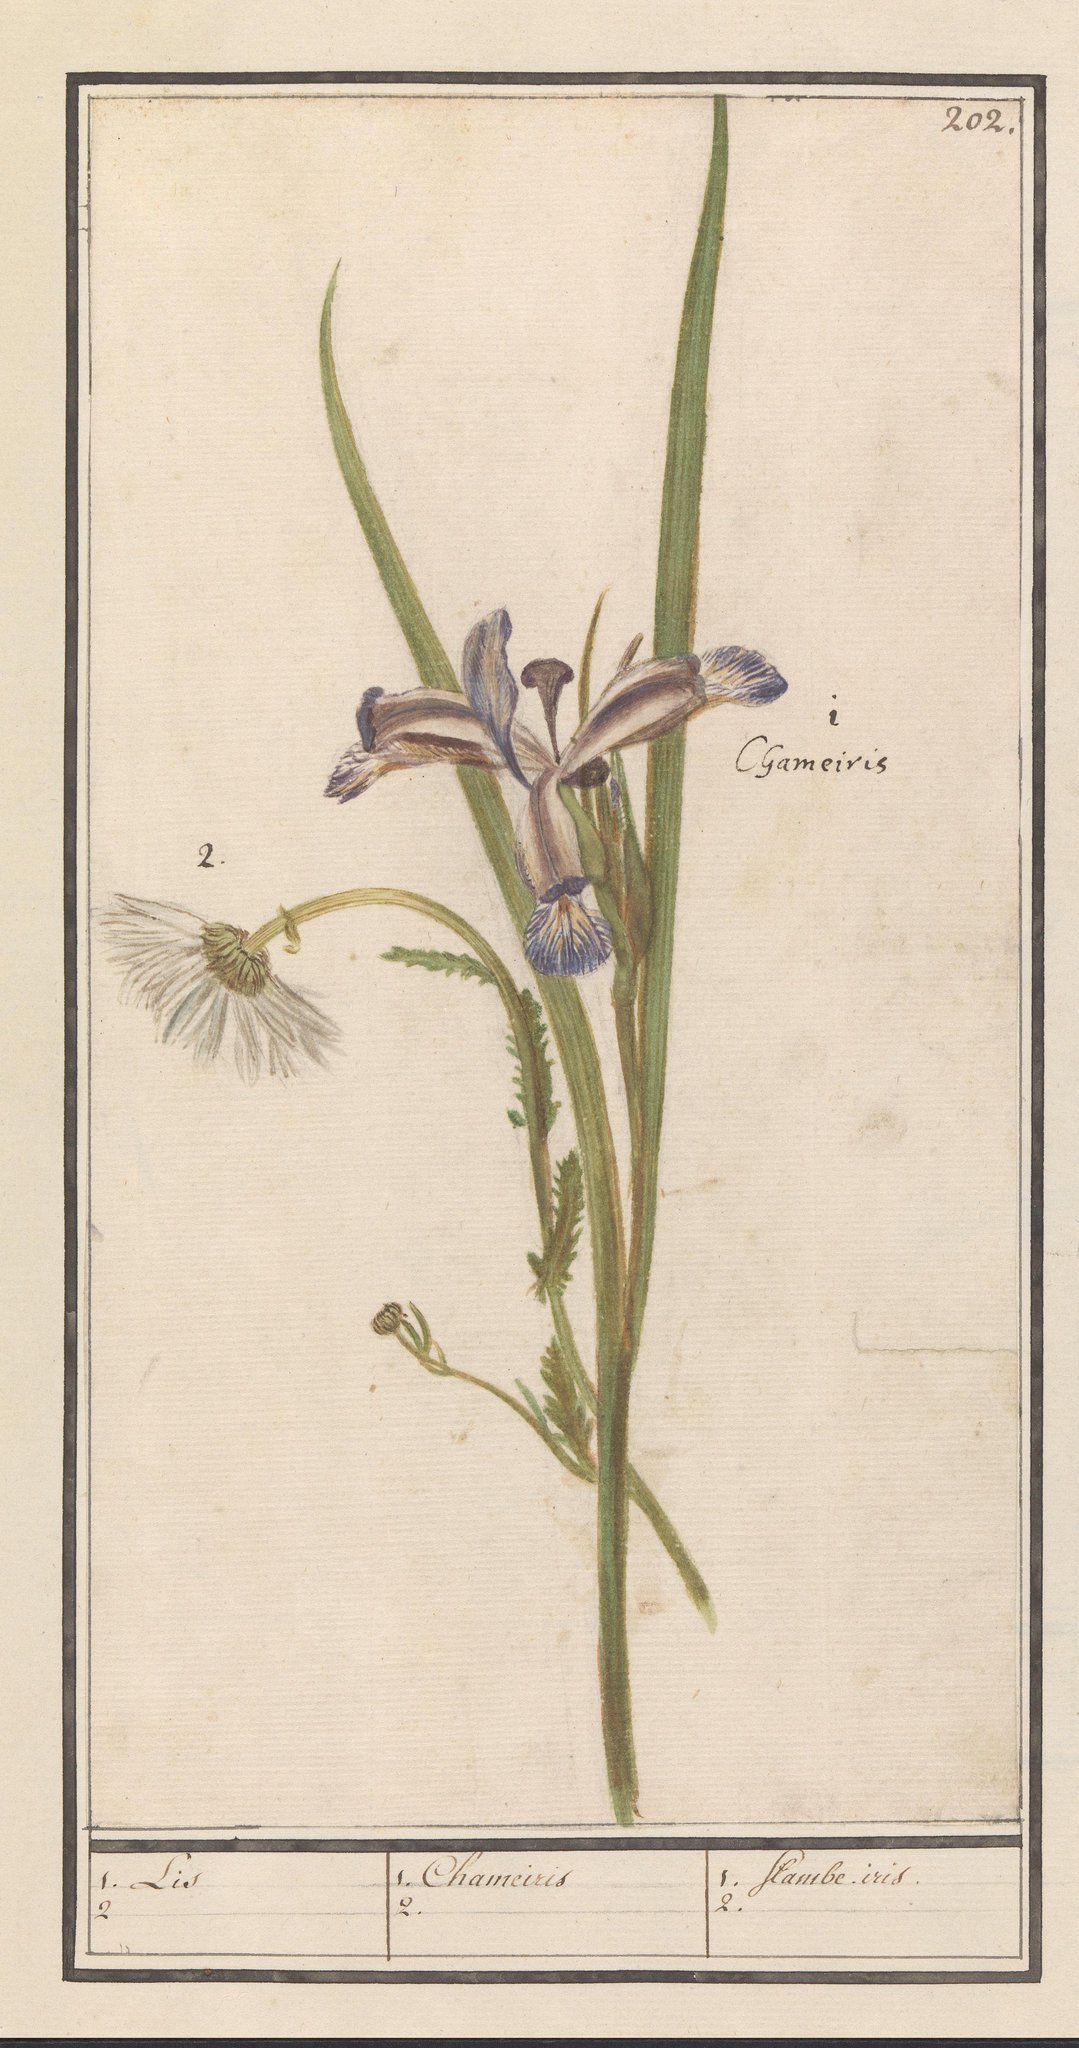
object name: drawing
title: Blauwe lis (Iris sibirica)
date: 1596-1610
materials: chalk, paint, ink, paper, watercolor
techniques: brush, pen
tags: flowers: iris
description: Blauw lis, met een andere hangende (onbekende) bloem. Genummerd rechtsboven: 202. Rechts de Latijnse naam. Onderdeel van het derde album met tekeningen van bloemen en planten. Tiende van twaalf albums met tekeningen van dieren, vogels en planten bekend rond 1600, gemaakt in opdracht van keizer Rudolf II. Met toelichting in Nederlands, Latijn en Frans.